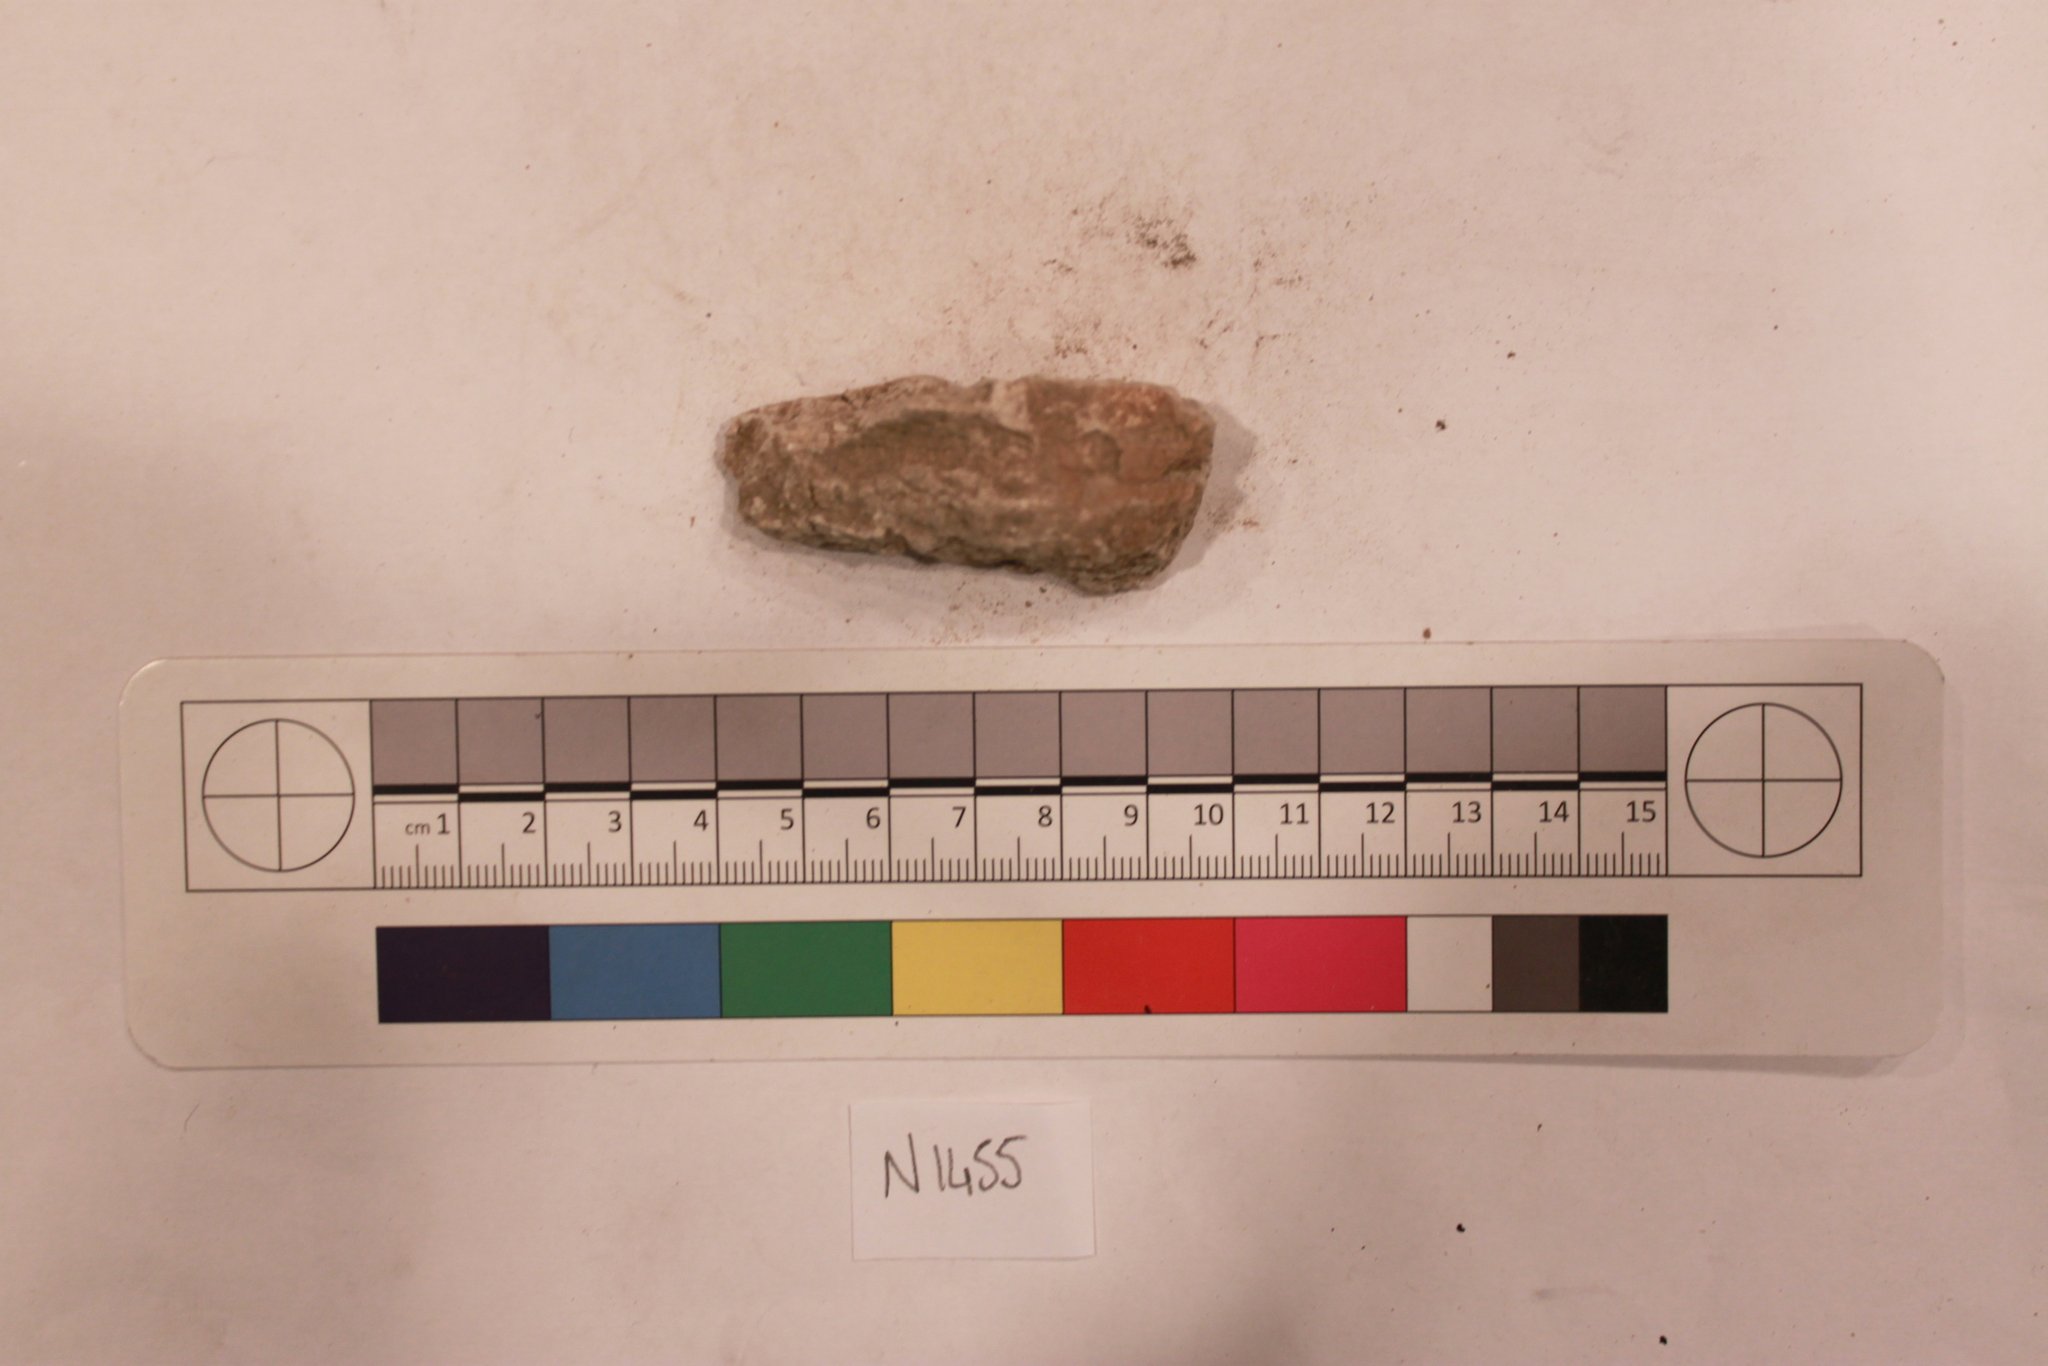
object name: fragment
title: Stucco Fragment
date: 701-1200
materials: plaster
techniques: carving, painting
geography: iran